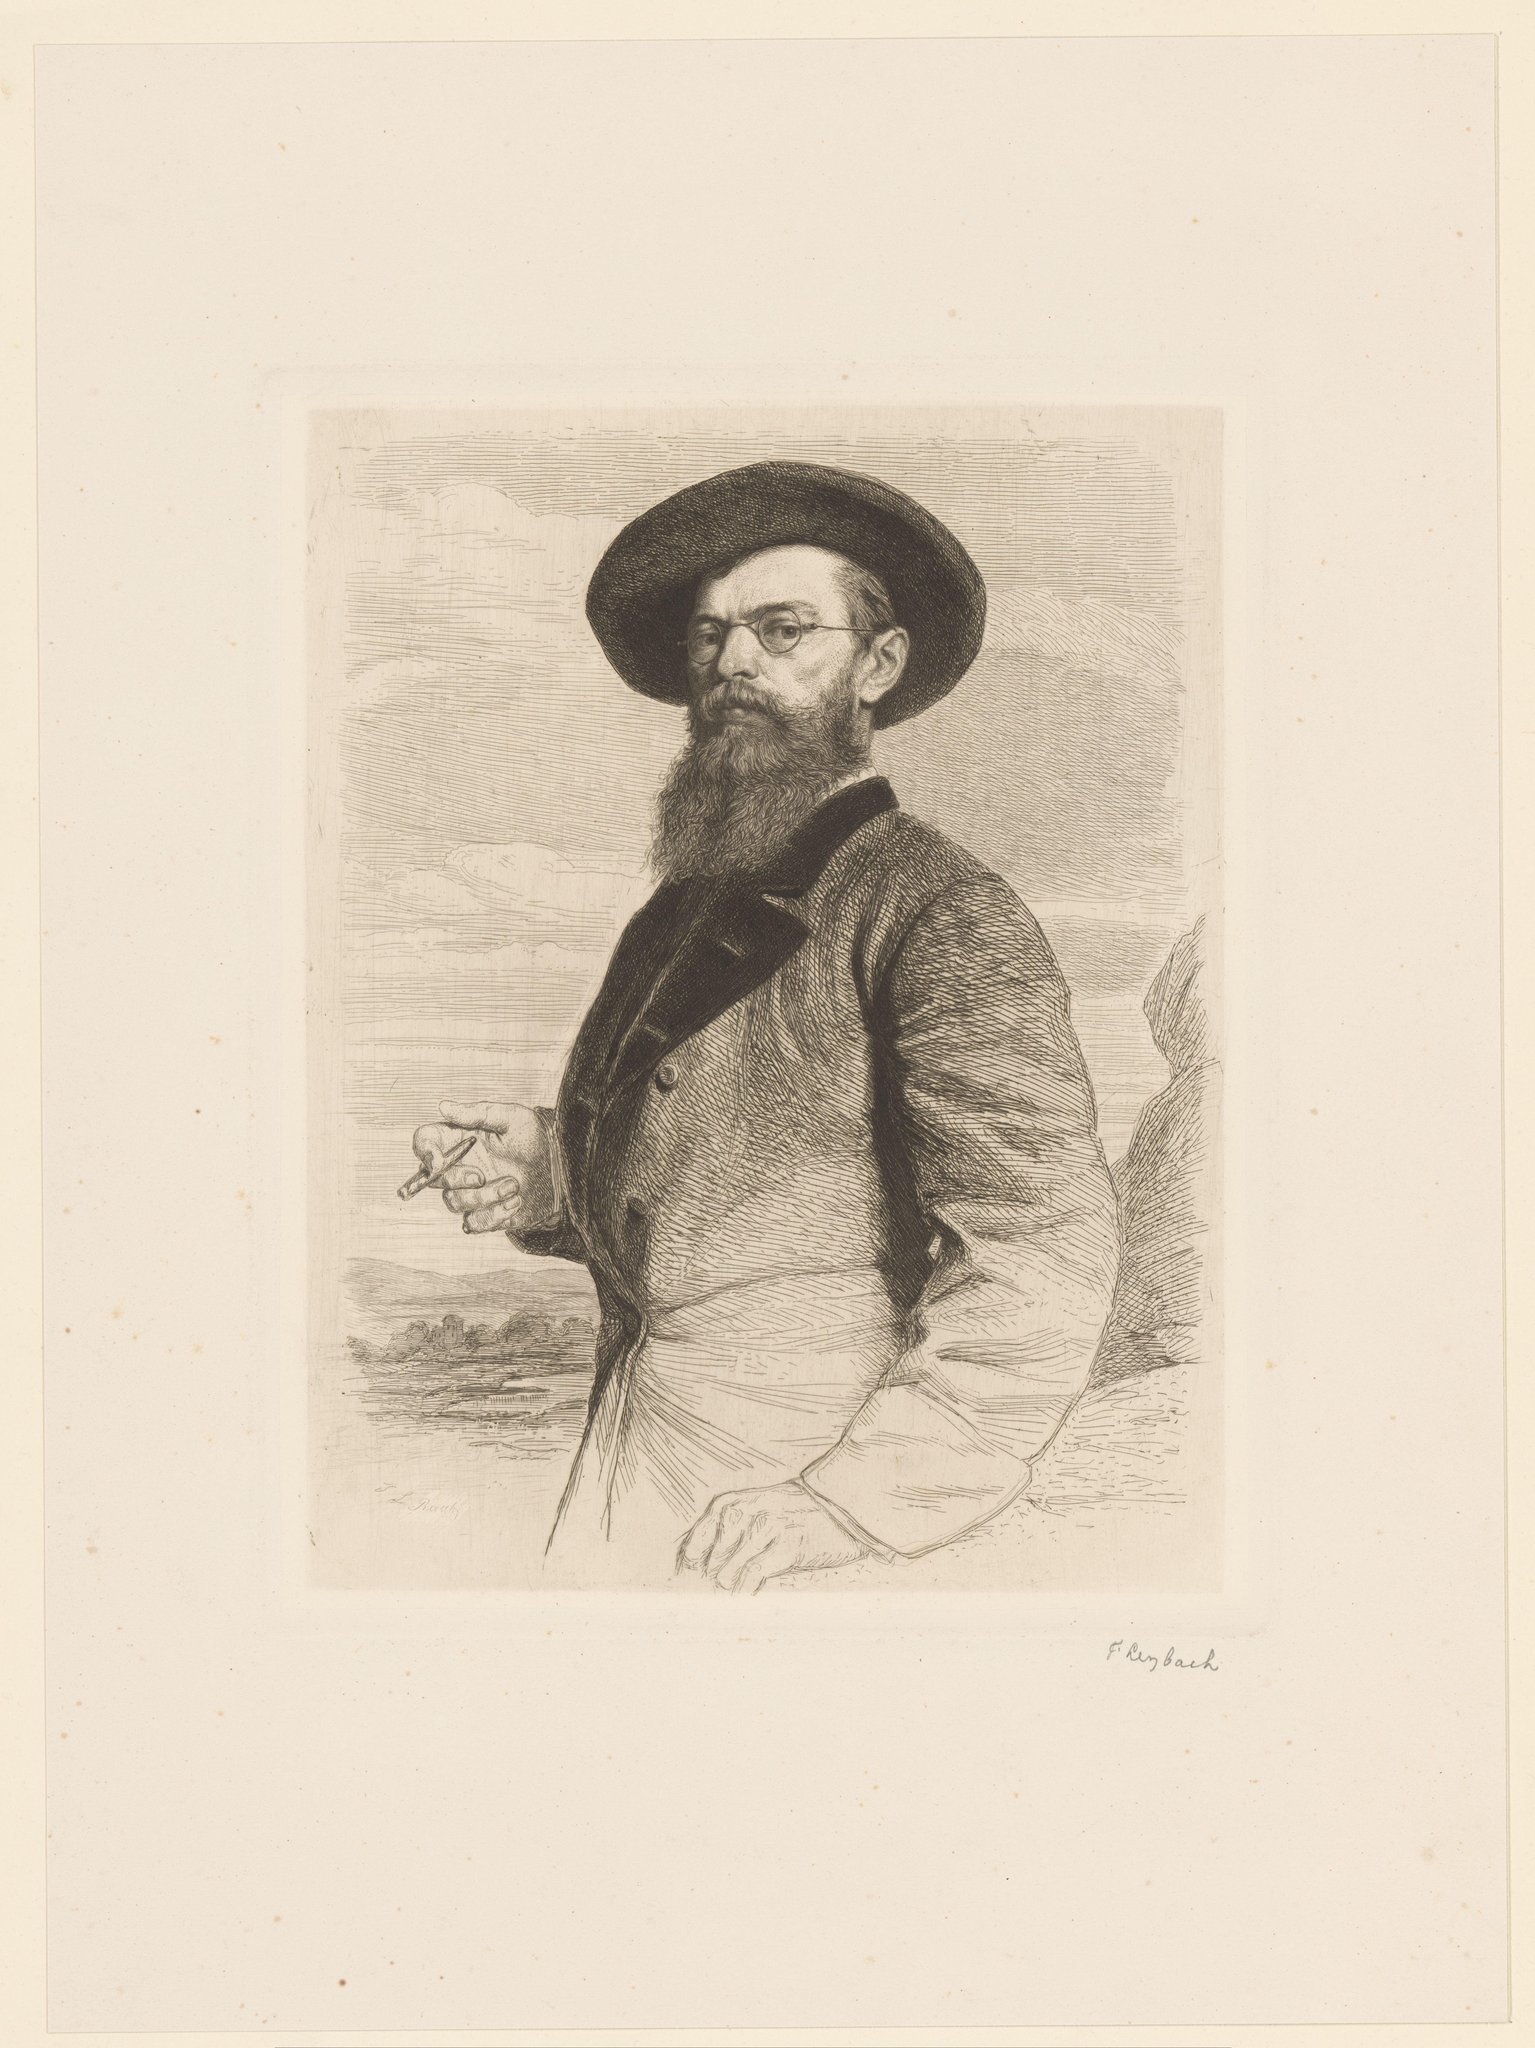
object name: print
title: Portret van Franz Seraph von Lenbach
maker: johann leonhard raab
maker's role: print maker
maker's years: 1825-1899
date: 1856-1899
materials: paper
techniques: etching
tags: painter, franz von lenbach, city-view, and landscape with man-made constructions, cigar, portrait, self-portrait of artist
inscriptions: collector's mark: Lugt 2228, name